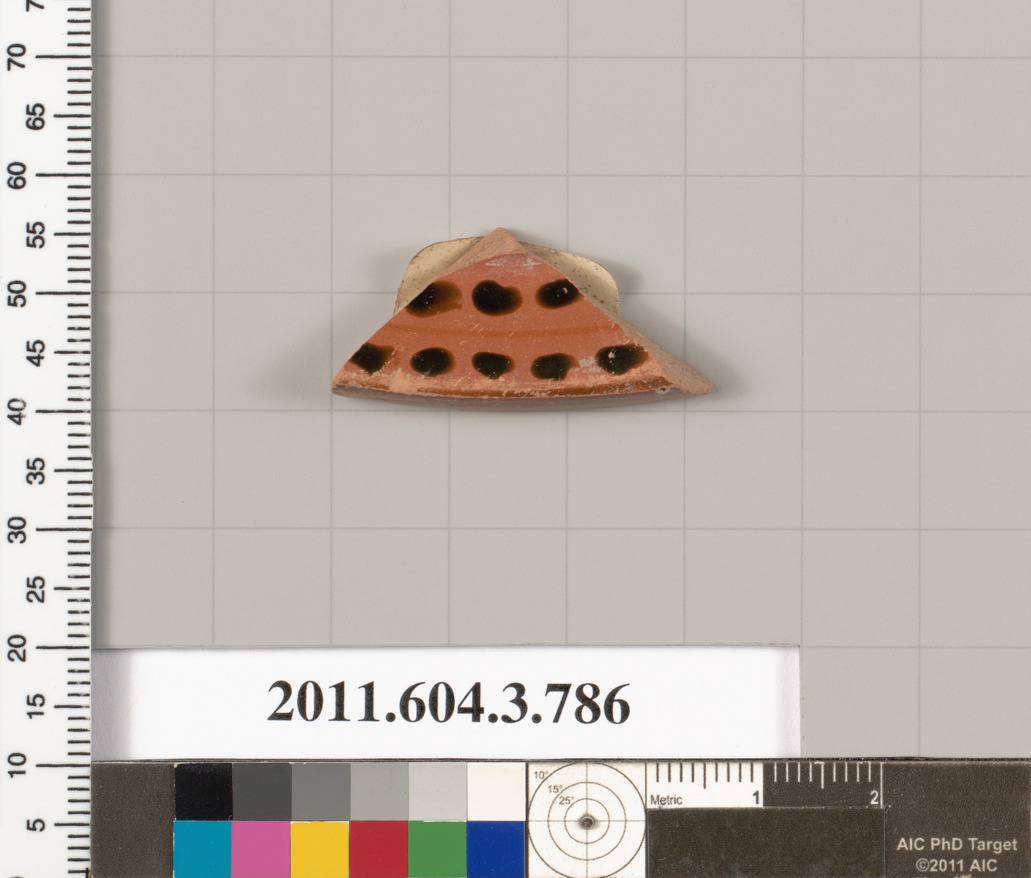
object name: lid fragment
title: Terracotta fragment of a lid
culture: greek, attic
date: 600-501 BCE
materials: terracotta